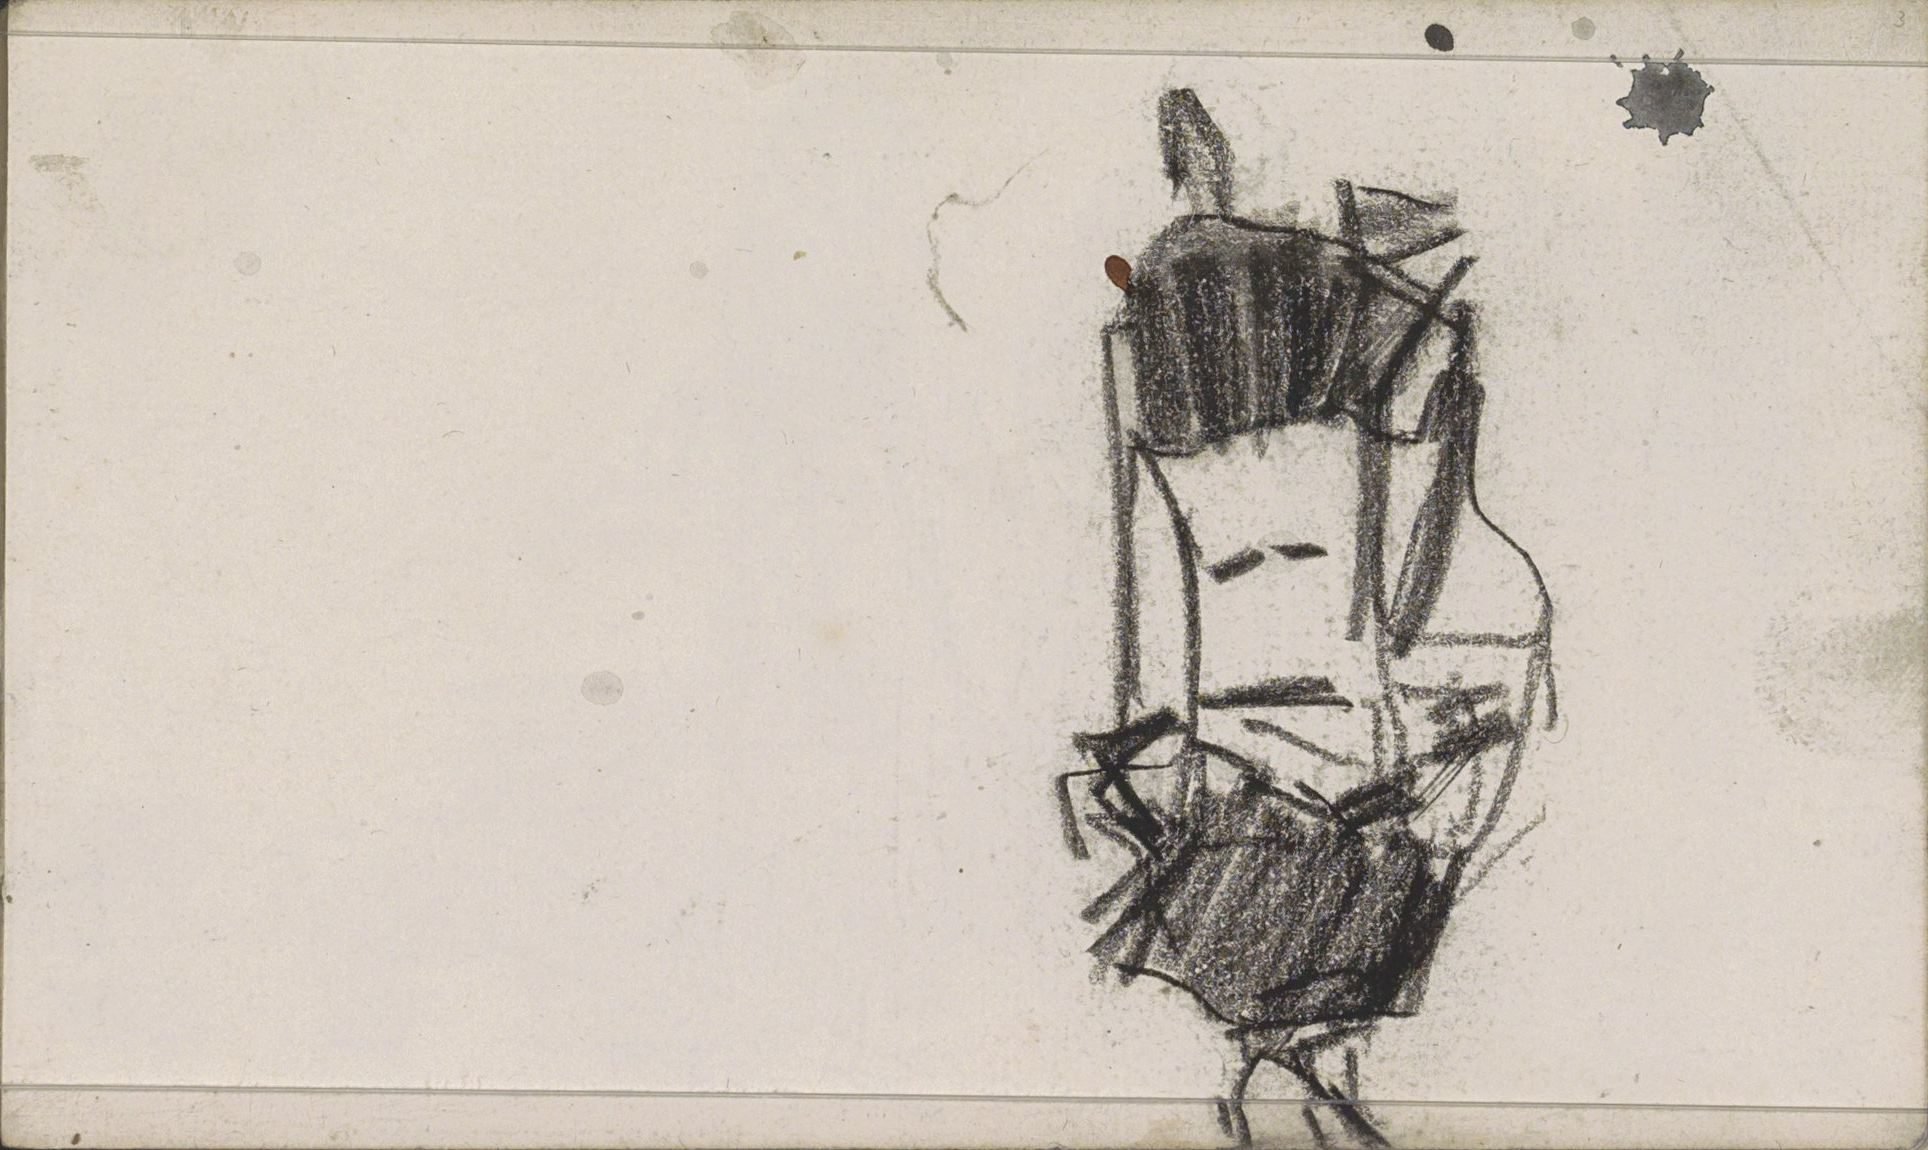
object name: sketchbook leaf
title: Staande vrouw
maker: isaac israels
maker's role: draughtsman, painter, print maker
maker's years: 1865-1934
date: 1875-1934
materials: chalk, paper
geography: the hague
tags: adult woman (+ standing)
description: Pagina 3 uit schetsboek XLVIII met 62 pagina's.